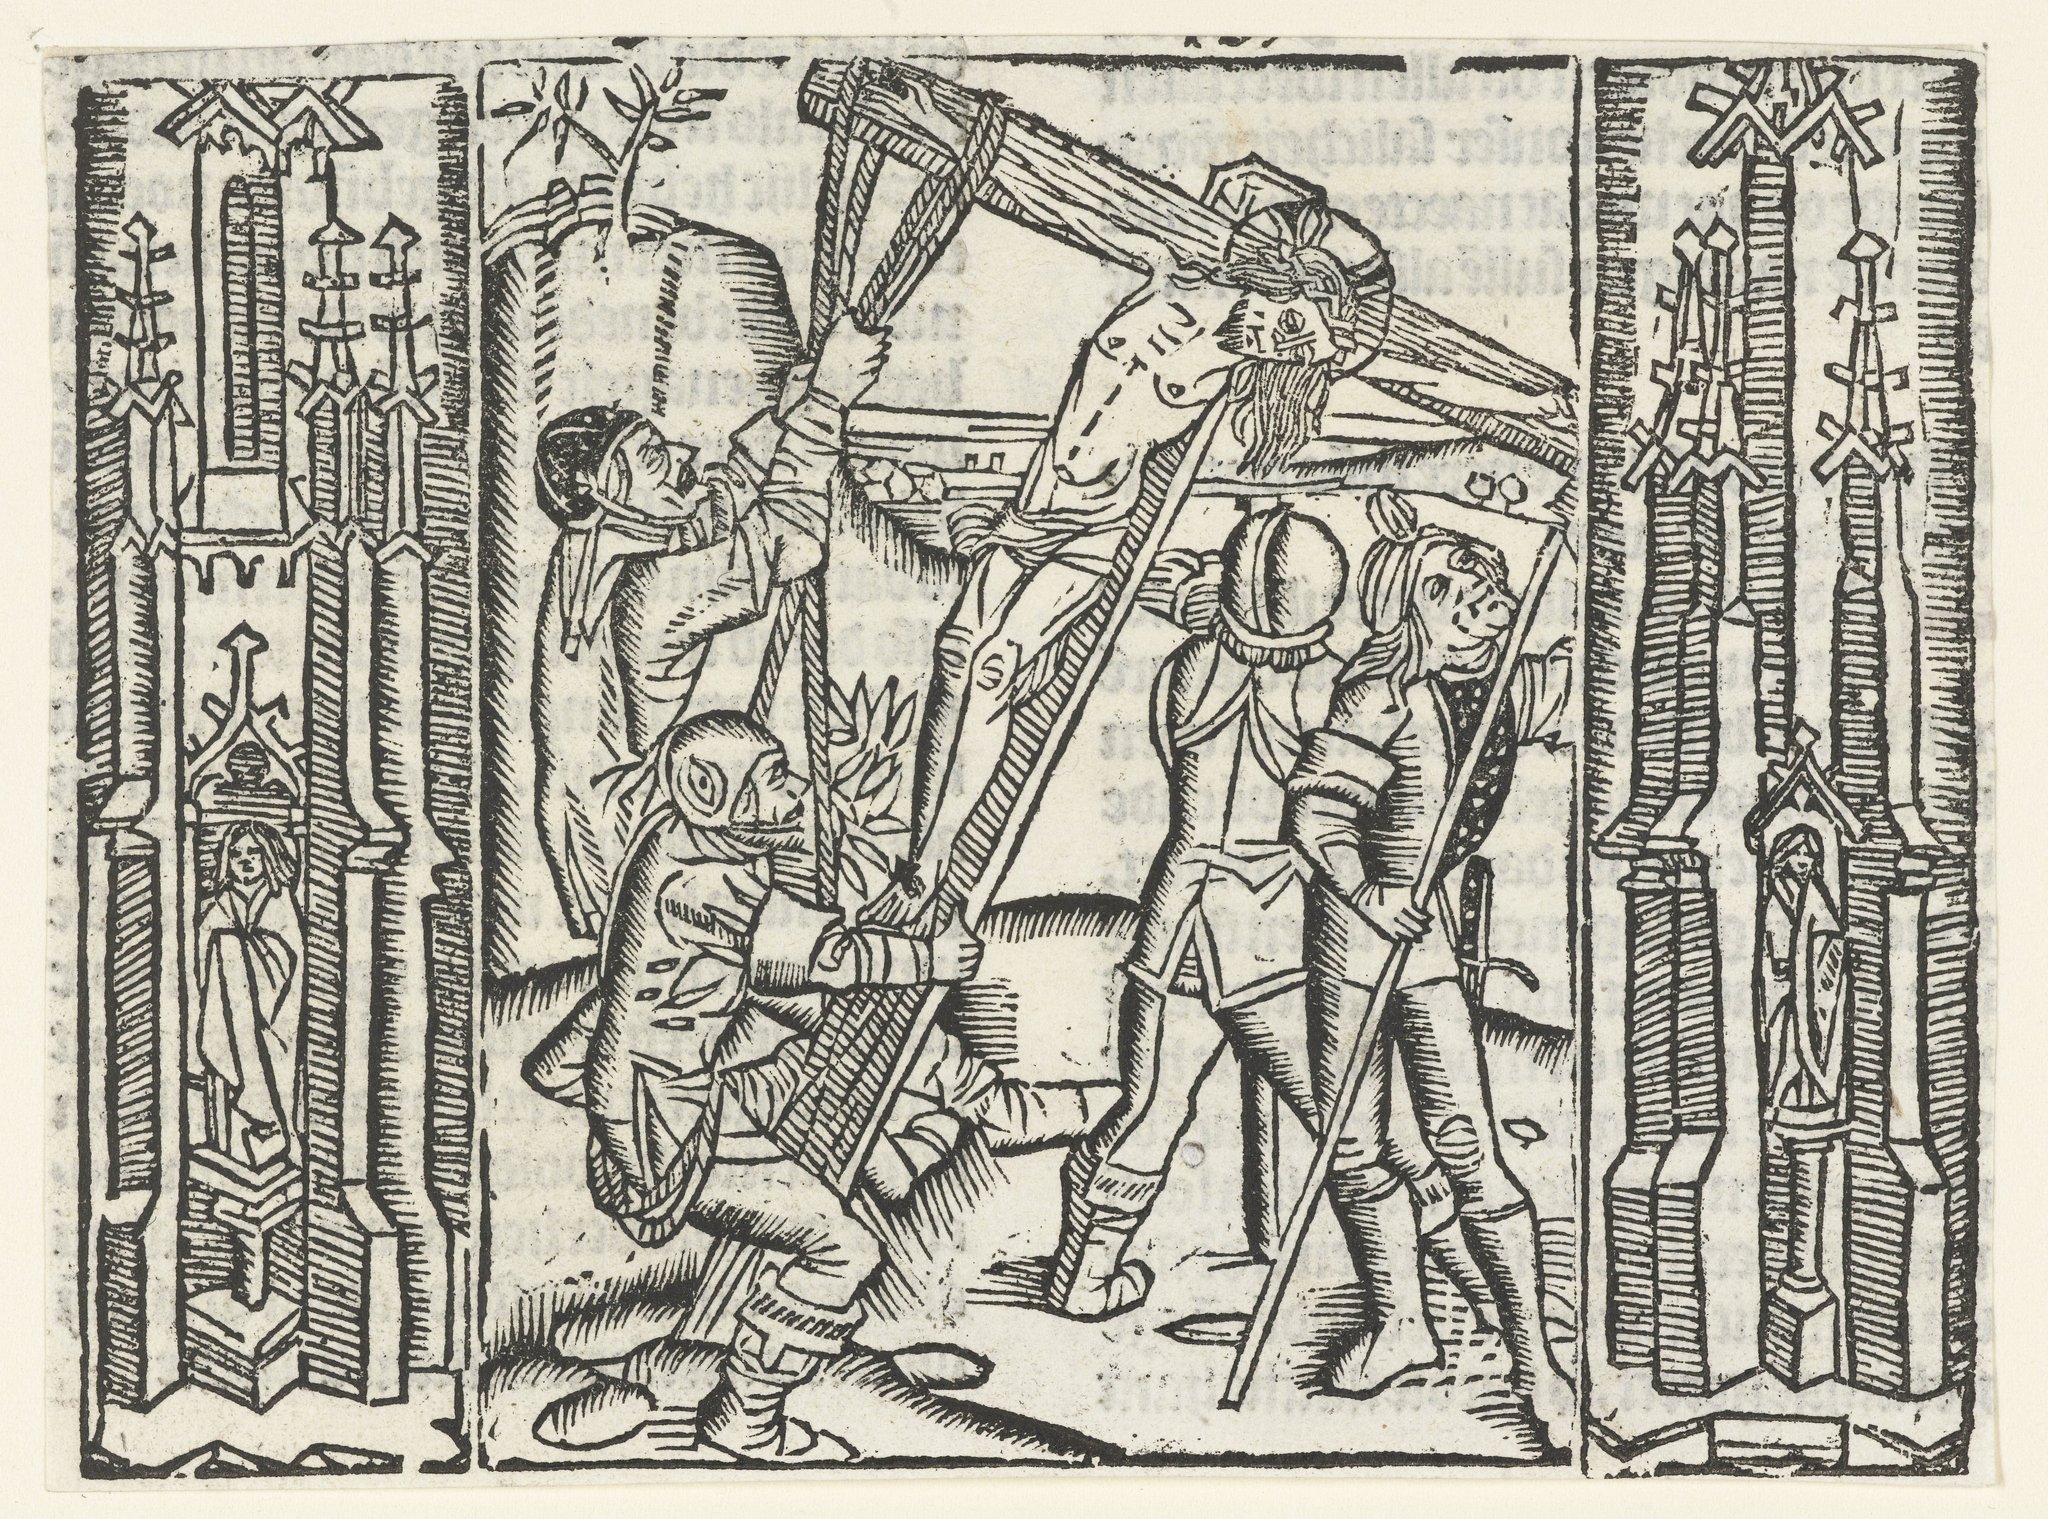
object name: print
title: De oprichting van het kruis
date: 1480-1500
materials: paper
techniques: woodcut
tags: raising of the cross to which christ is nailed already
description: Eén blad van 113 uit Ludolphus de Saxonia, "Dit es dleué ons liefs heeren ihesu christi". Anonieme Nederlandse vertaling. Uitgegeven door Henrick Eckert van Homberch te Antwerpen in 1503. Botke, K. Deze 113 houtsneden, die meestal reeds in vroege Nederlandse boeken gebruikt zijn, worden toegeschreven aan de tweede Meester van Delft, de Meester van de Delbecq-Schreiber-passie en de Meester van de Virgo inter Virgines. In Conway (1884) en in "De gulden passer"(1951) zijn ook eerdere versies opgenomen. Botke, K.